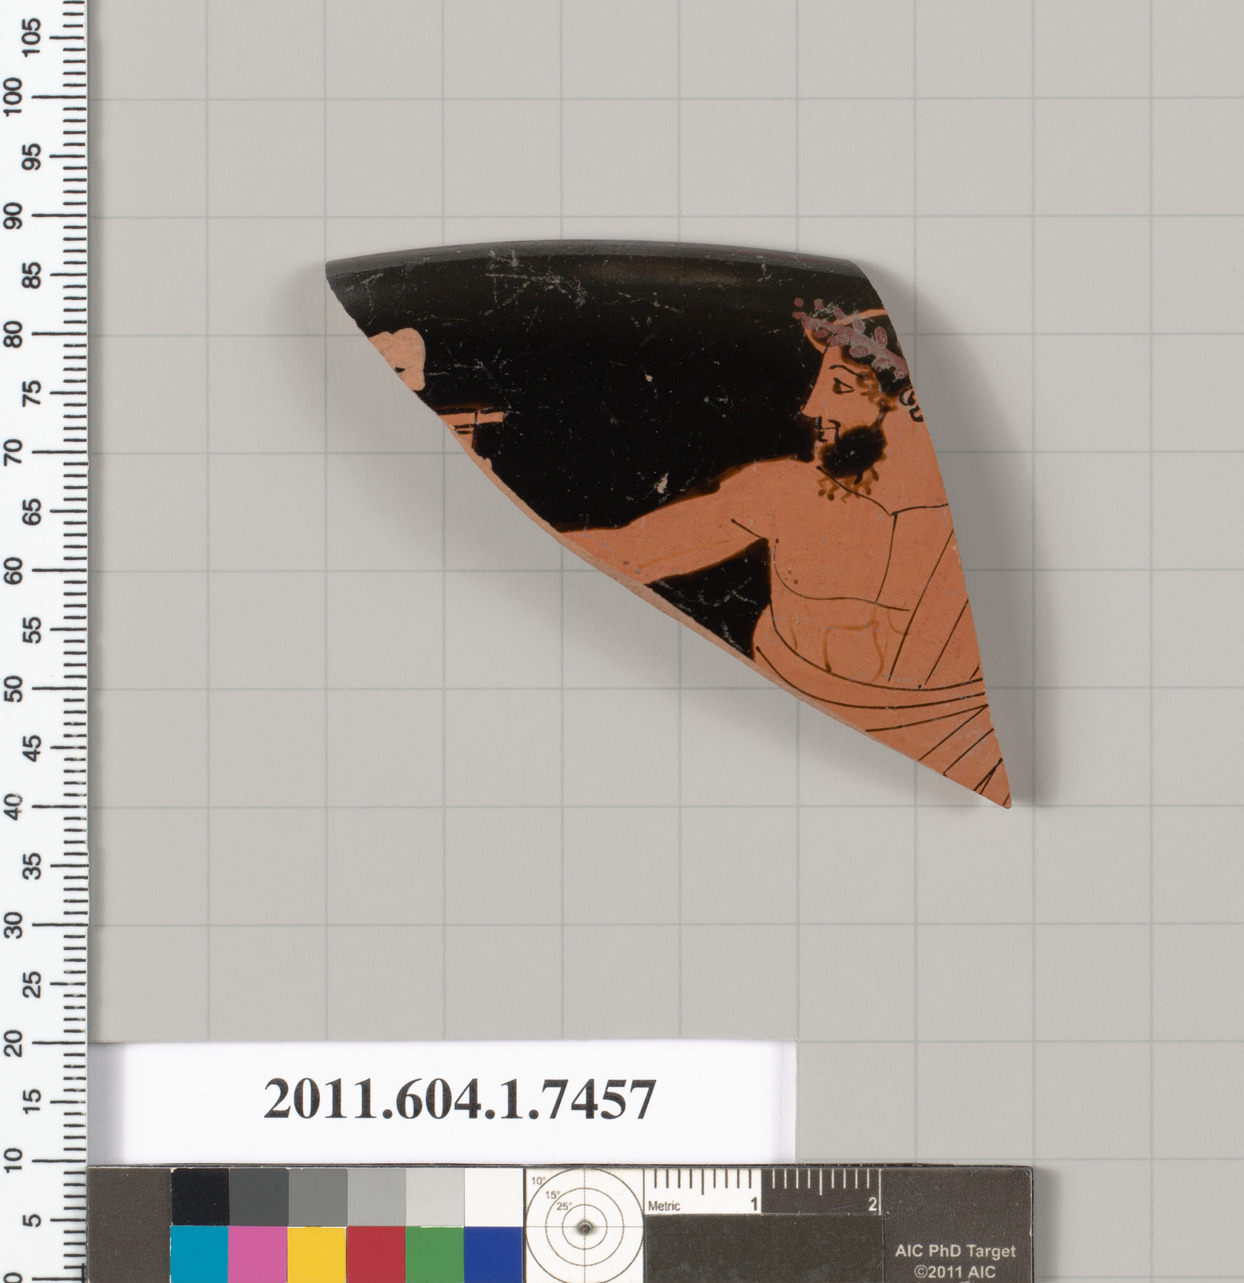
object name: kylix fragment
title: Terracotta rim fragment of a kylix (drinking cup)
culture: greek, attic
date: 470-460 BCE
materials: terracotta